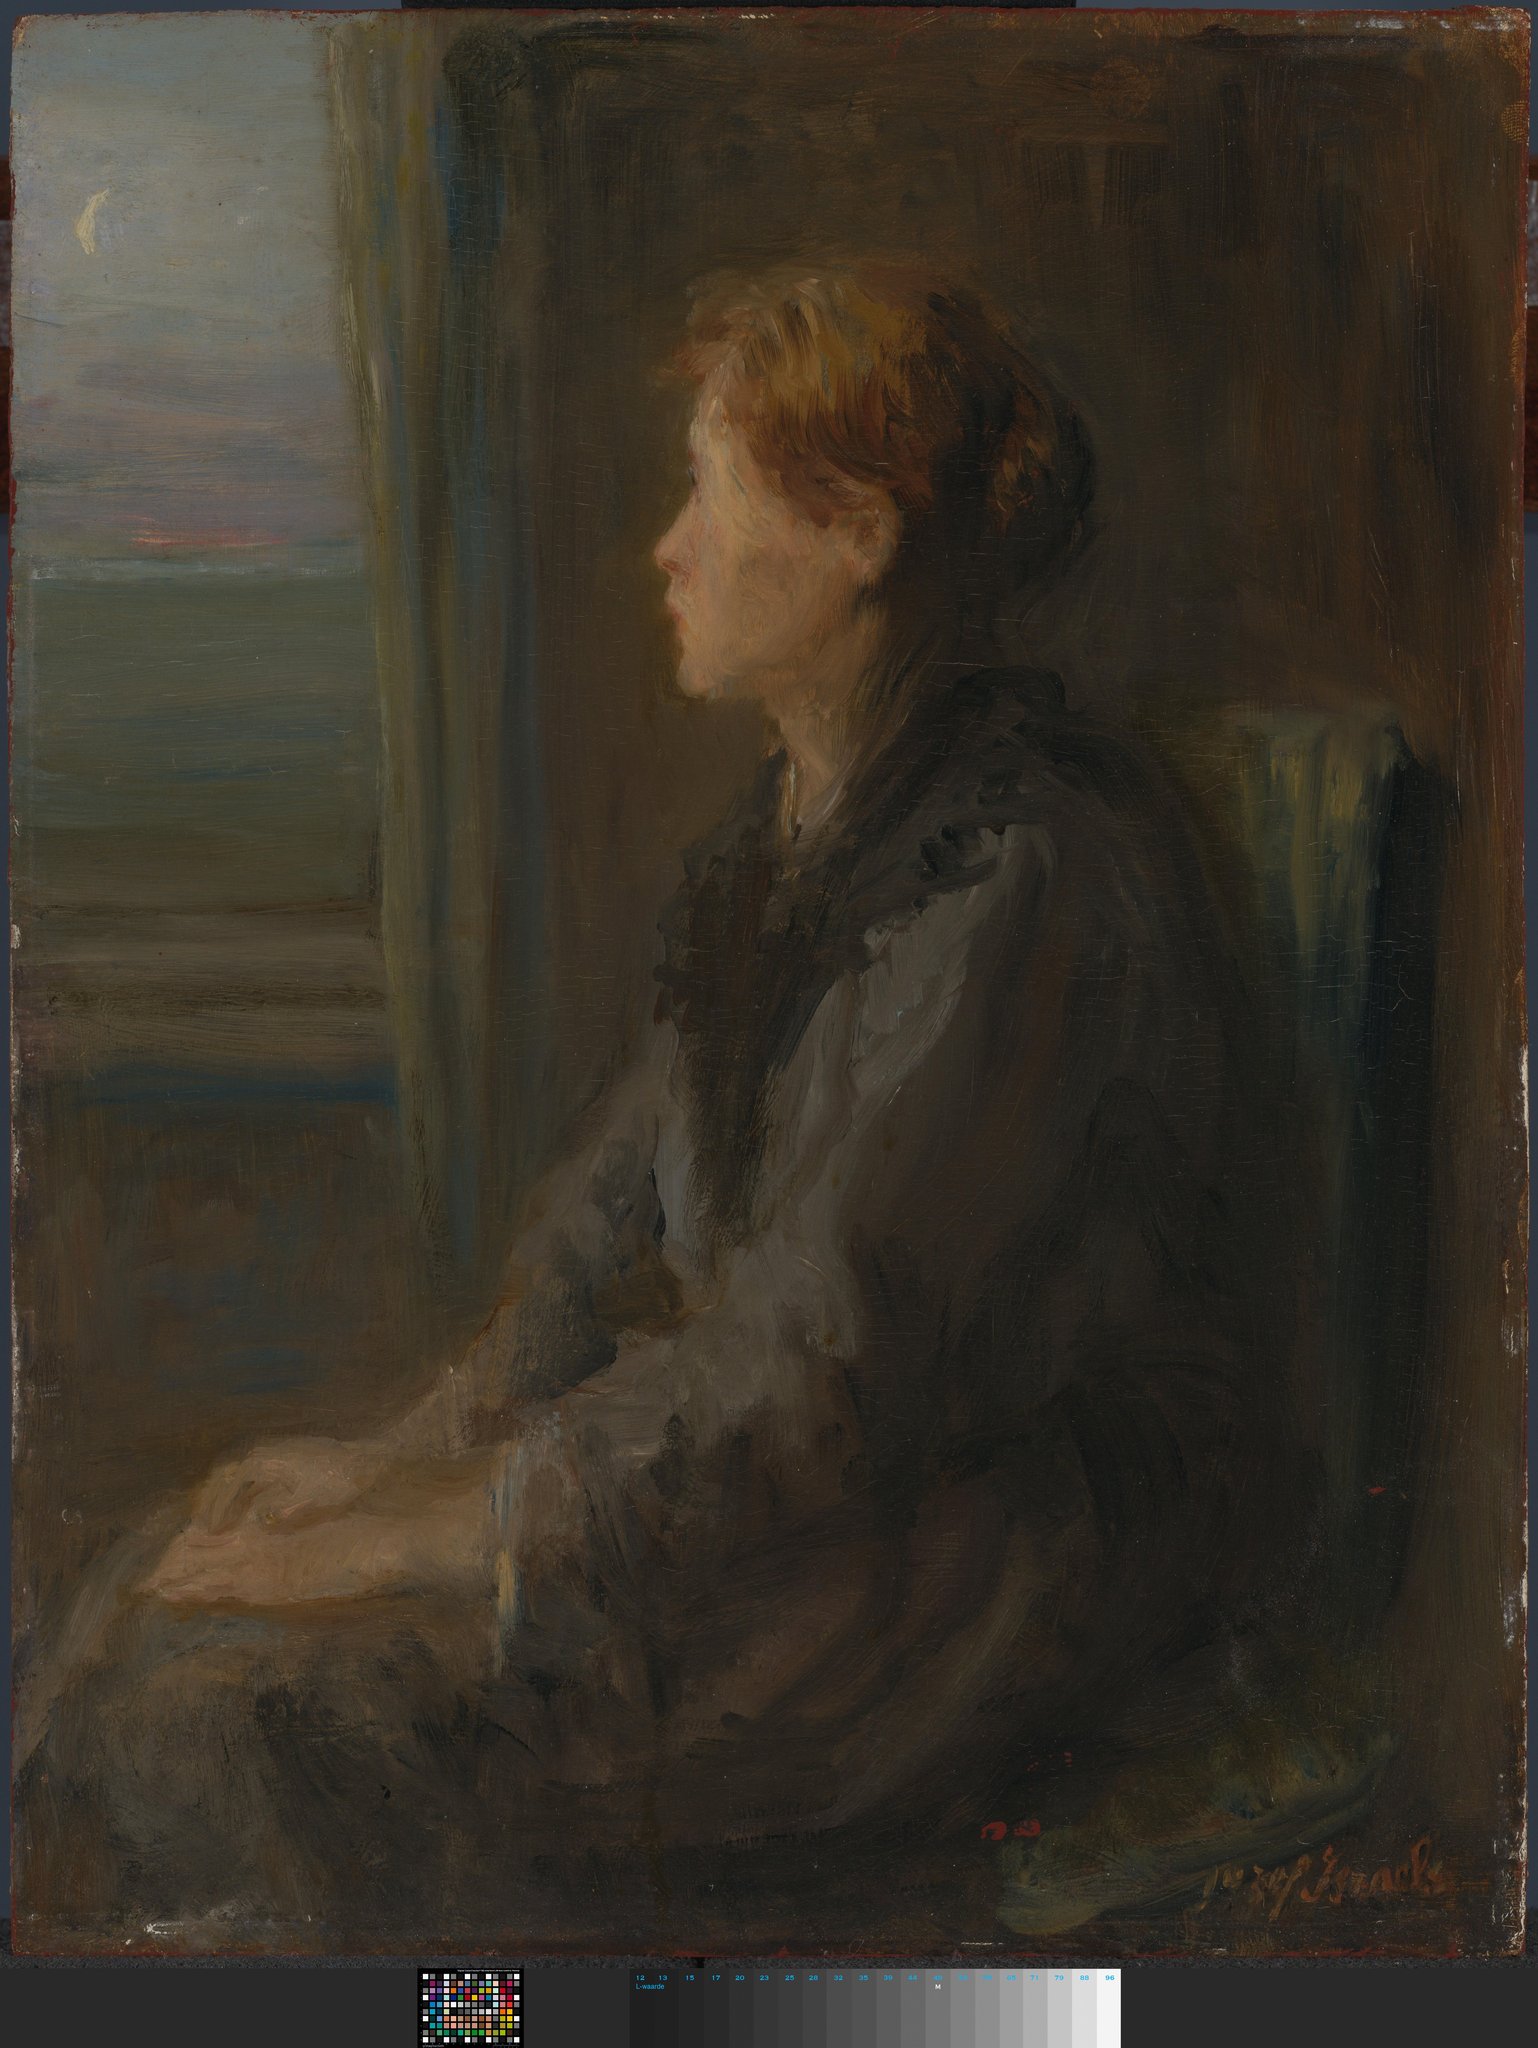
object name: painting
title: Woman at a Window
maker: jozef israëls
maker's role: draughtsman, painter, print maker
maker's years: 1824-1911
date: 1880-1911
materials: oil, panel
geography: netherlands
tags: sitting figure - aa - female human figure, human figure at (open) window, seen from inside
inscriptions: signature: ‘Jozef Israels’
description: Een vrouw zittend aan een raam. Zittend voor een gordijn, naar links gewend, met de handen op de knieën. Door het venster uitzicht op zee.